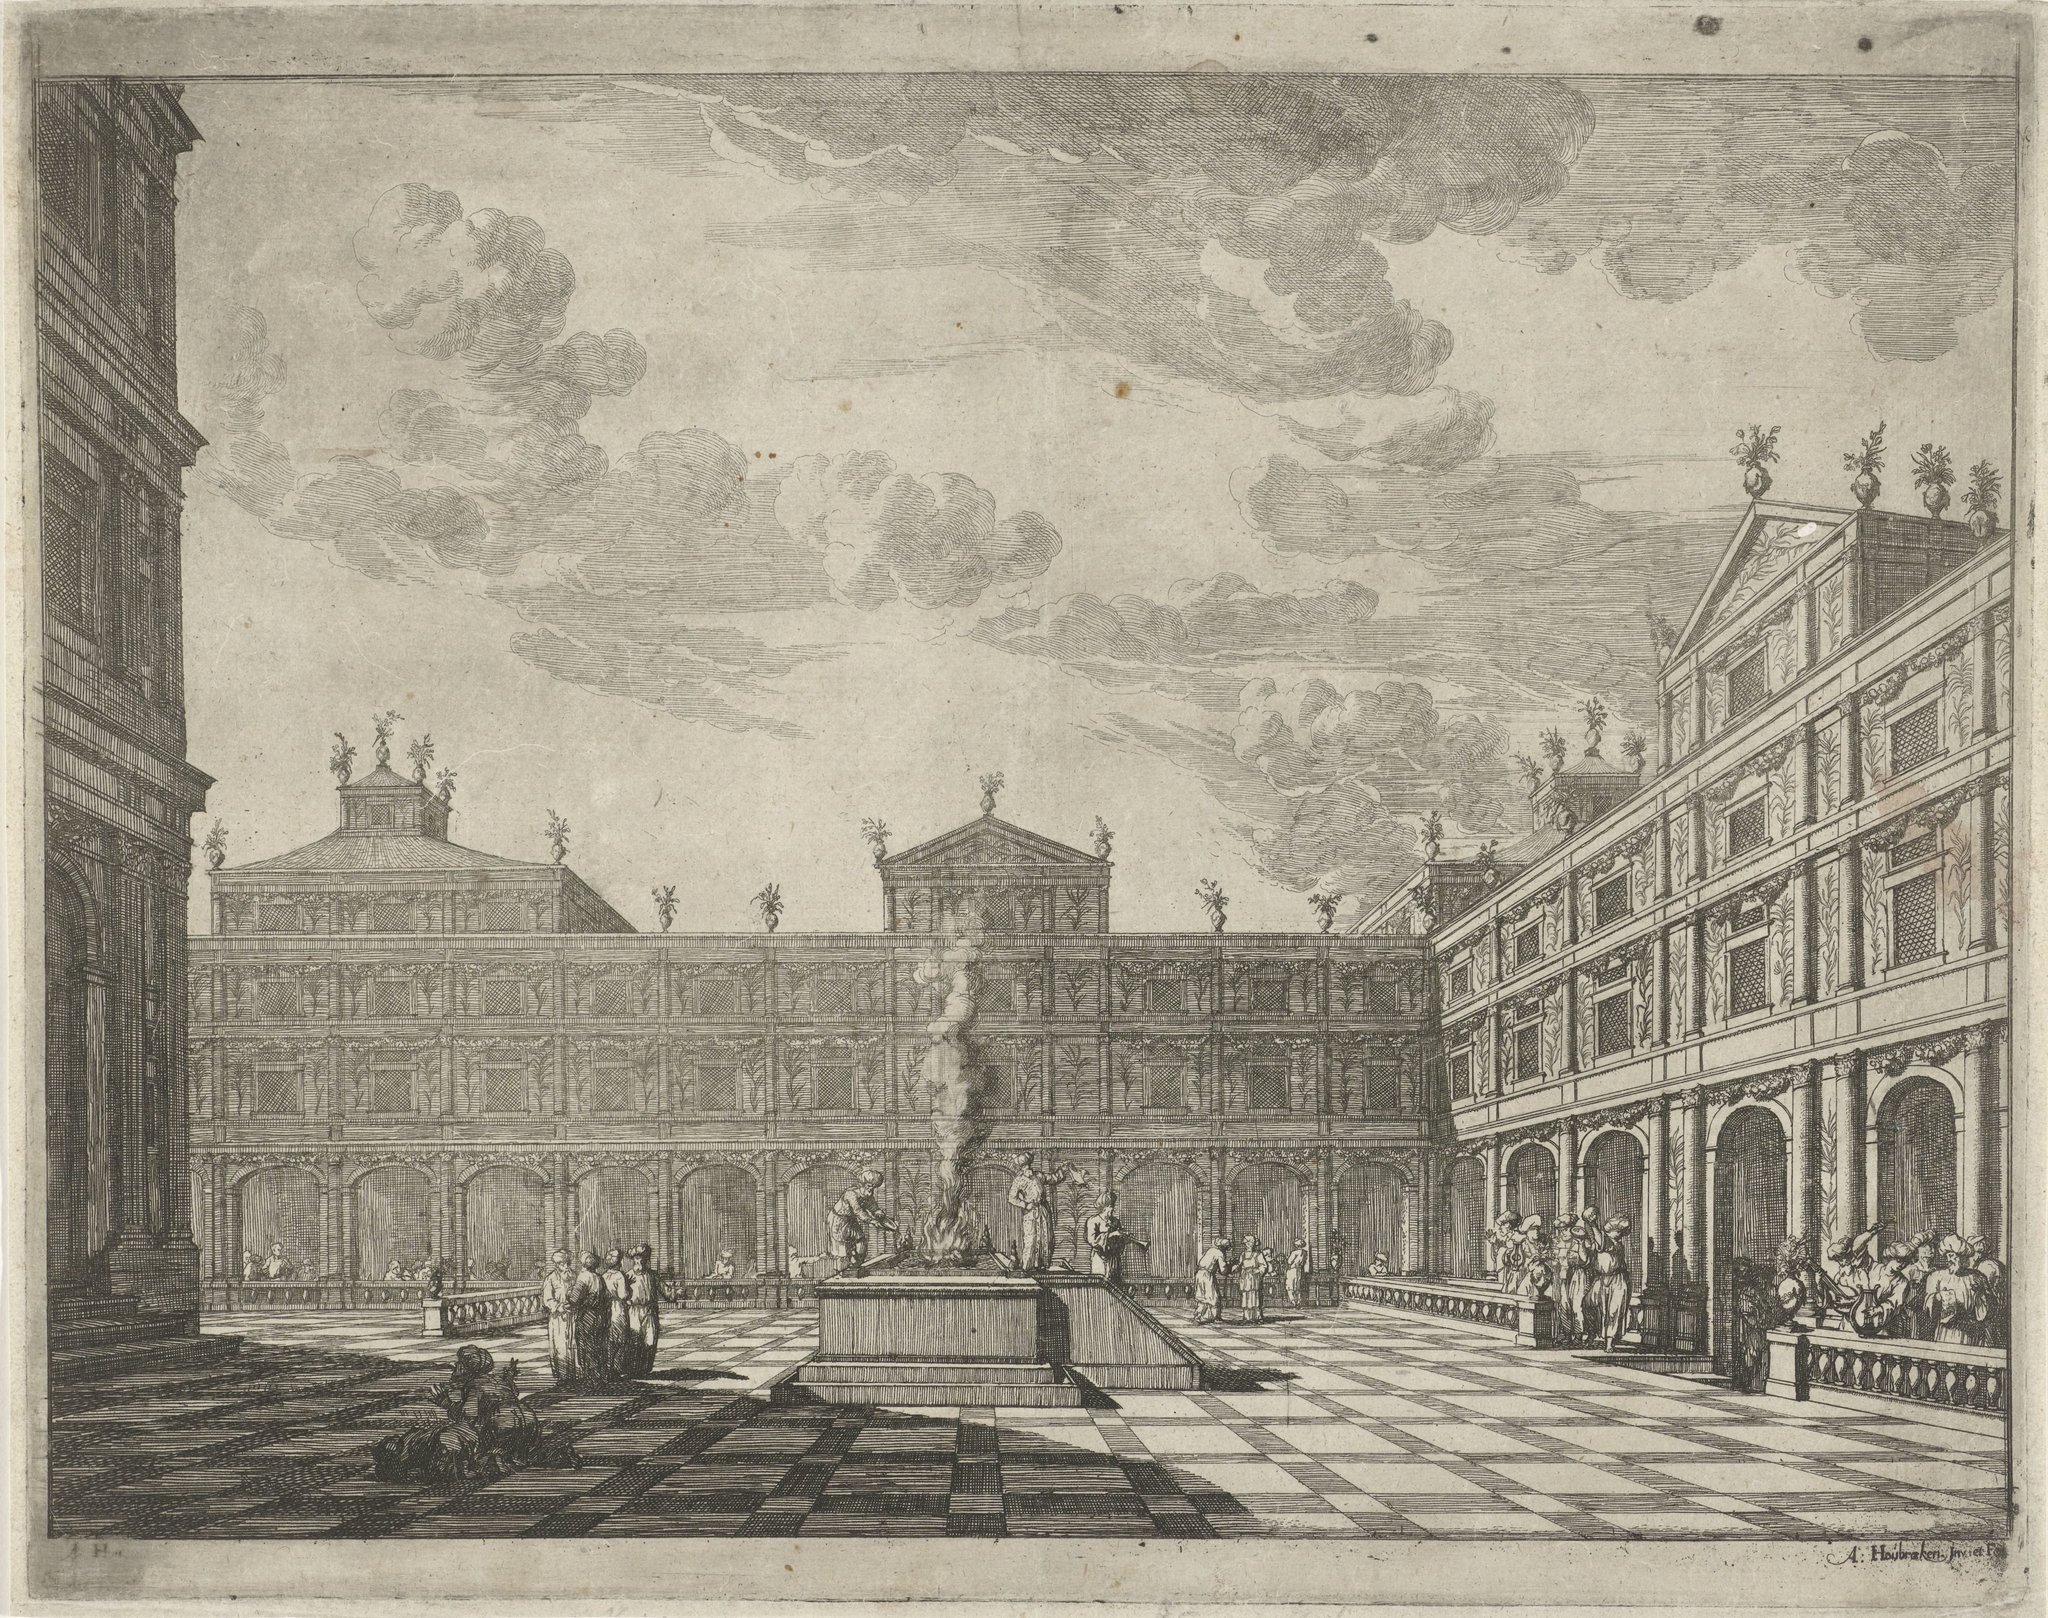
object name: print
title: Interieur van een synagoge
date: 1704-1706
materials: paper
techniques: etching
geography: dordrecht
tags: the temple (in general) ~ jewish religion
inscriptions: collector's mark: Lugt 2228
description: Prent ook gebruikt in: Salomon van Til, Digt- sang- en speel-konst (...) der Hebreeen (...) dienende (...) tot een beter verstand der goddelijke psalmen. Dordrecht: Dirk Goris, 1706.